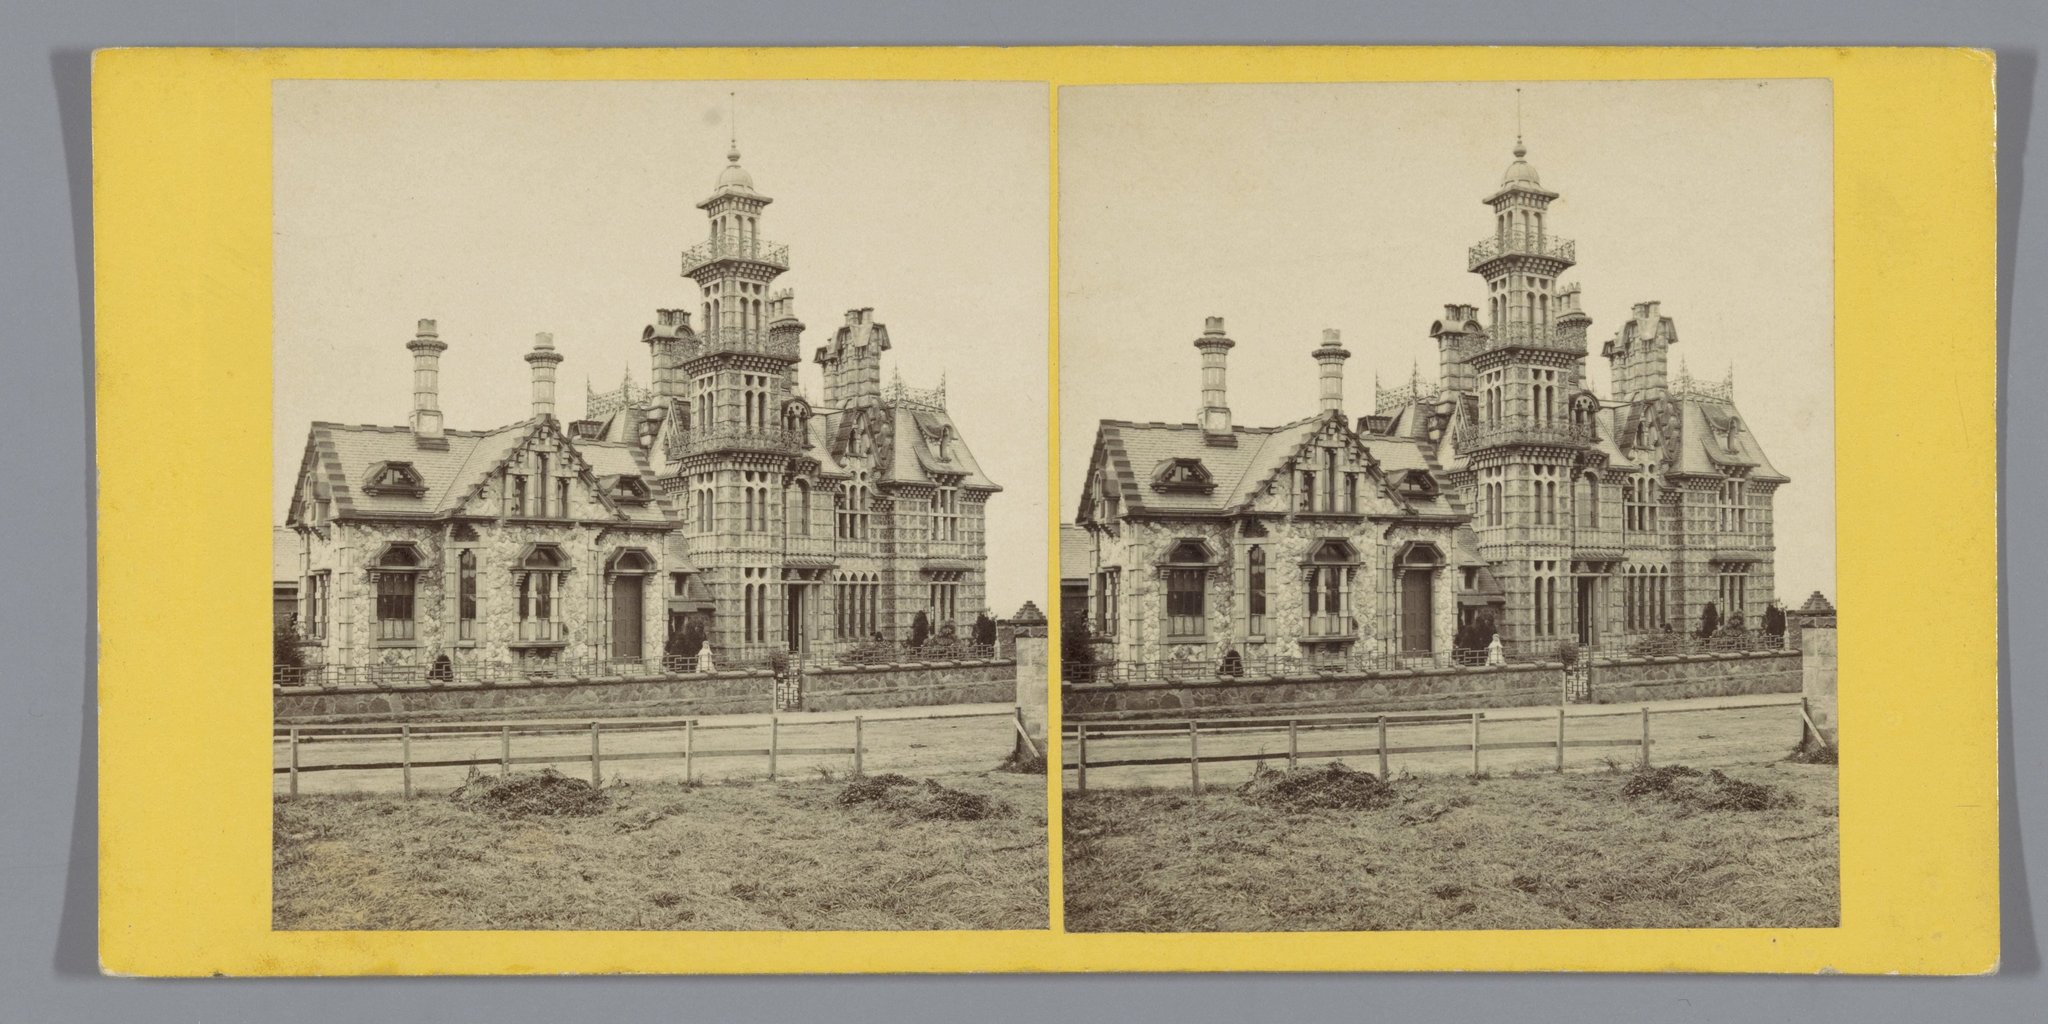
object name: stereograph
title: Villa Rockville in Edinburgh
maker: george washington wilson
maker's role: publisher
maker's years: 1823-1893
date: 1861-1870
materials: cardboard, paper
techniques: albumen print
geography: edinburgh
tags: tower, clock tower ~ monumental adornment, villa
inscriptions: number: ‘No. 688.’, inscription: ‘Registered.’, inscription: ‘Photographer, Aberdeen’